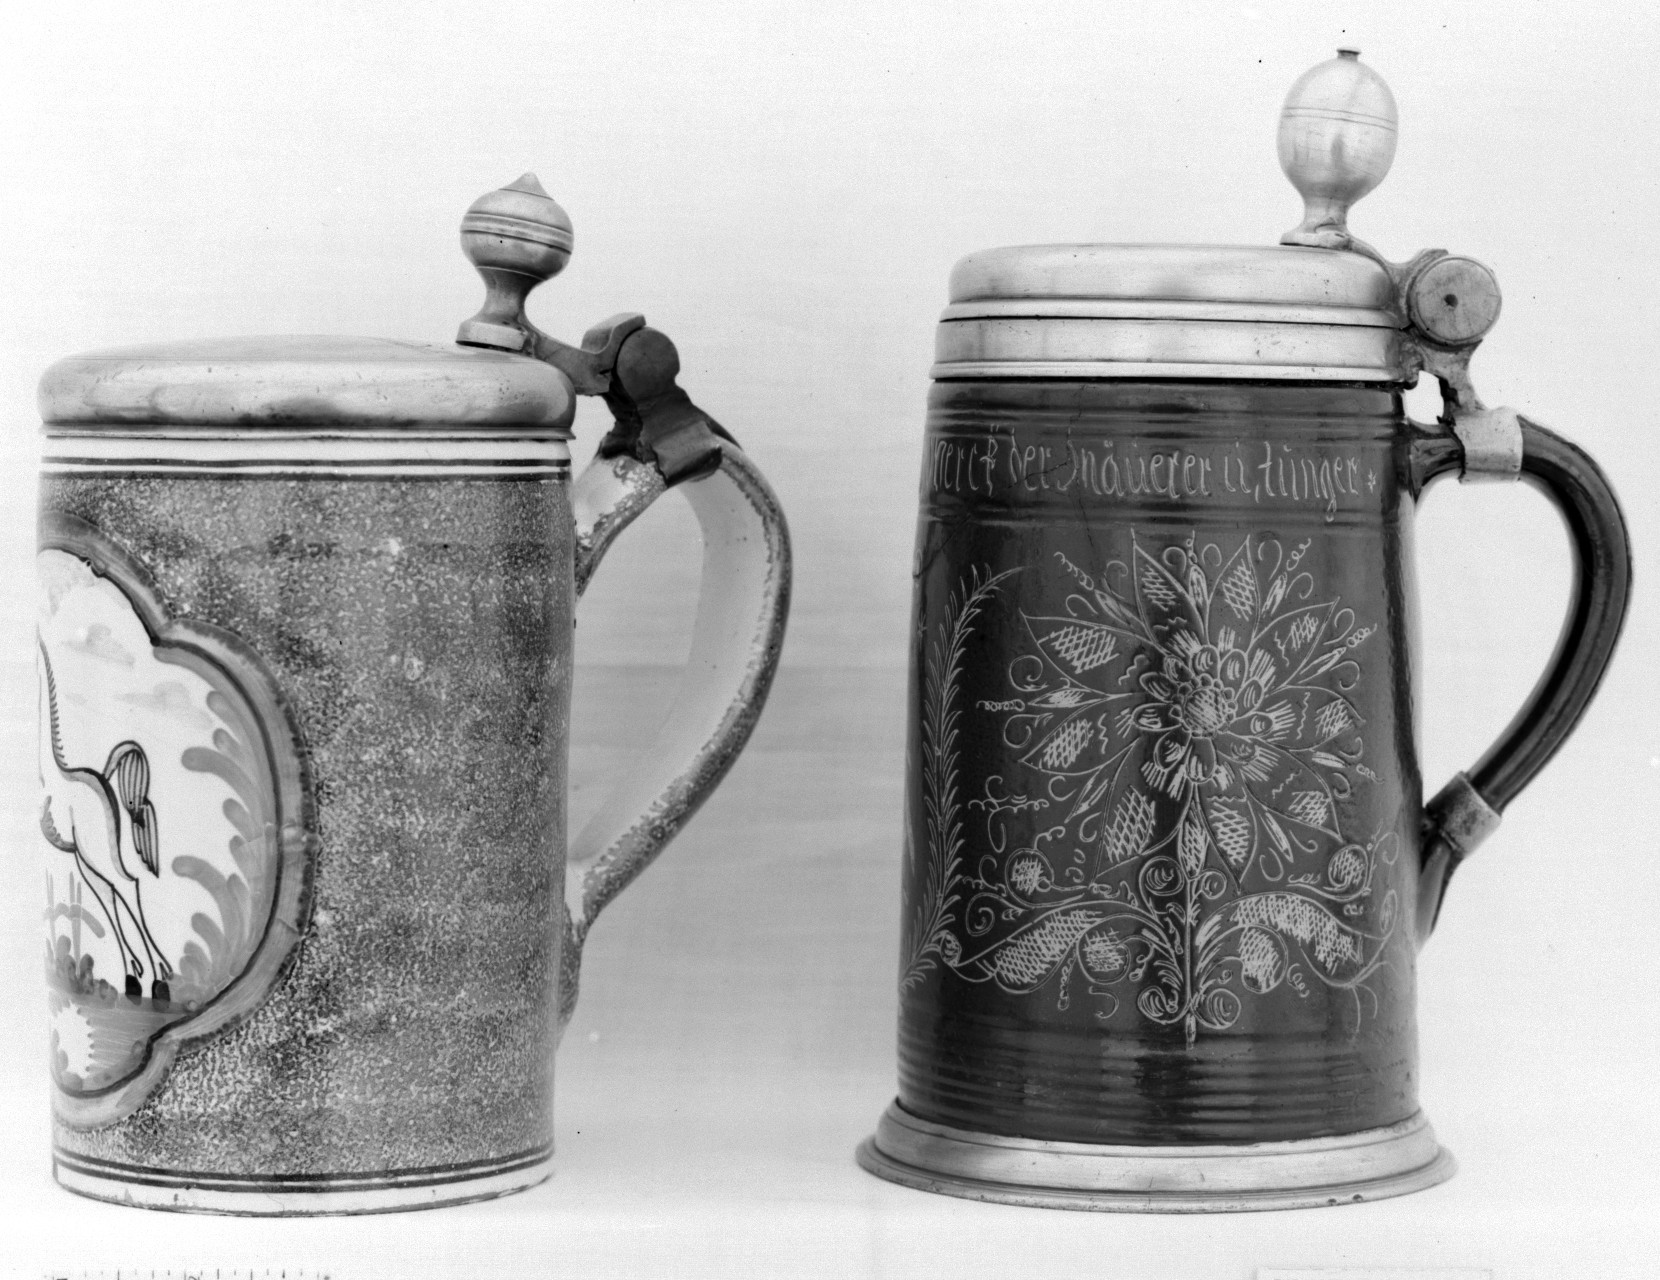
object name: tankard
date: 1701-1800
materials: earthenware, pewter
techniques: glazing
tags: animals,flowers